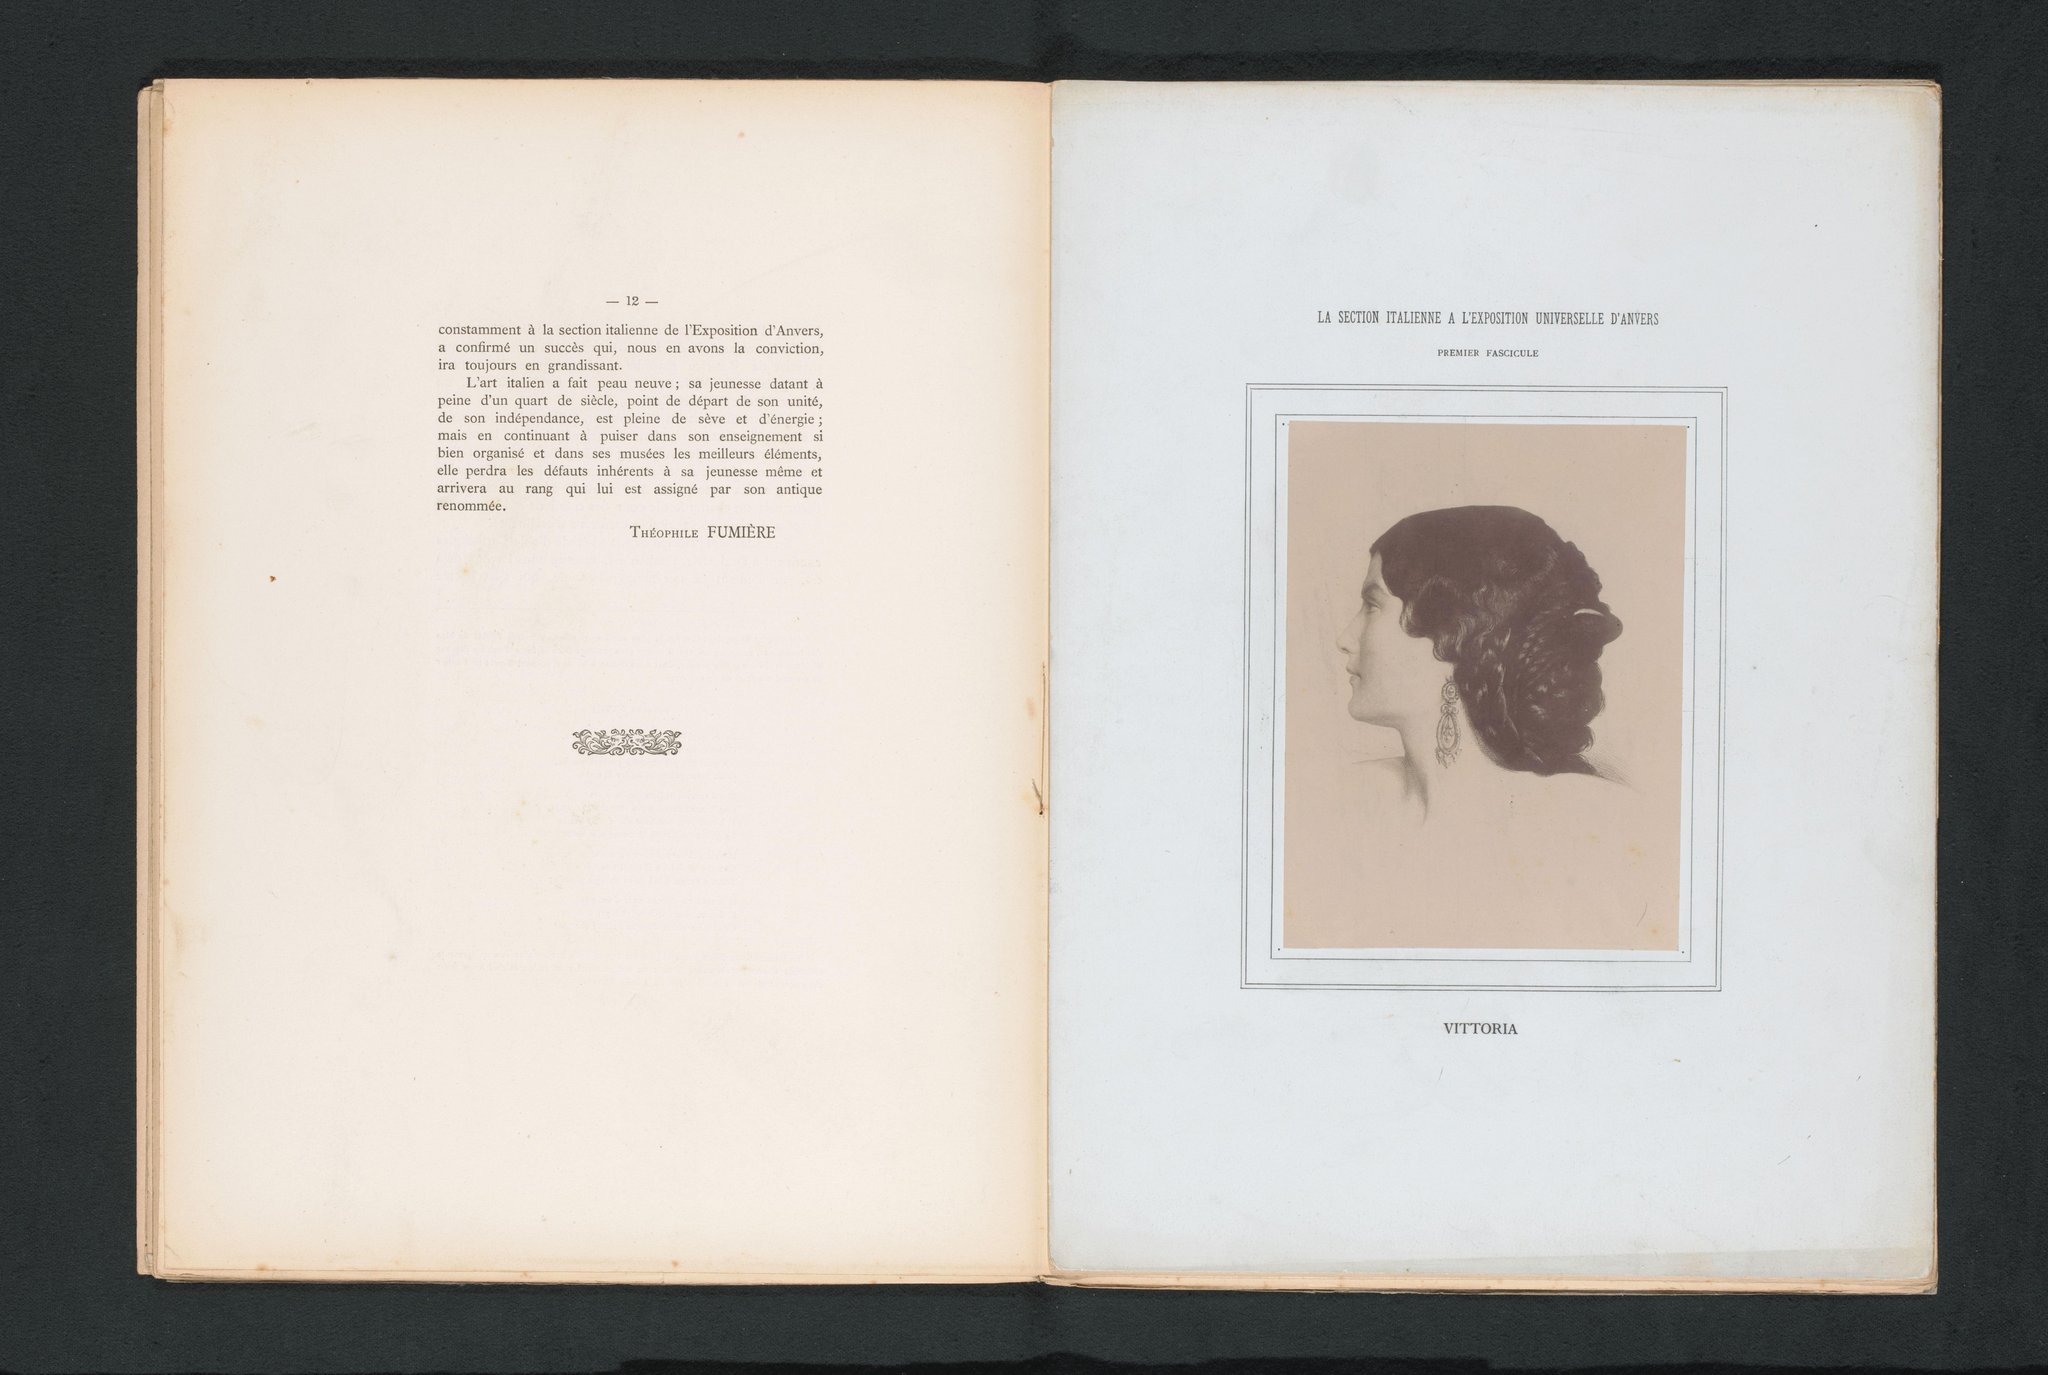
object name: reproduction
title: Vittoria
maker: Anonymous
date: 1880-1885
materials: photographic support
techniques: albumen print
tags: historical persons - bb - woman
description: Foto op losse plaat tegenover pagina 12.